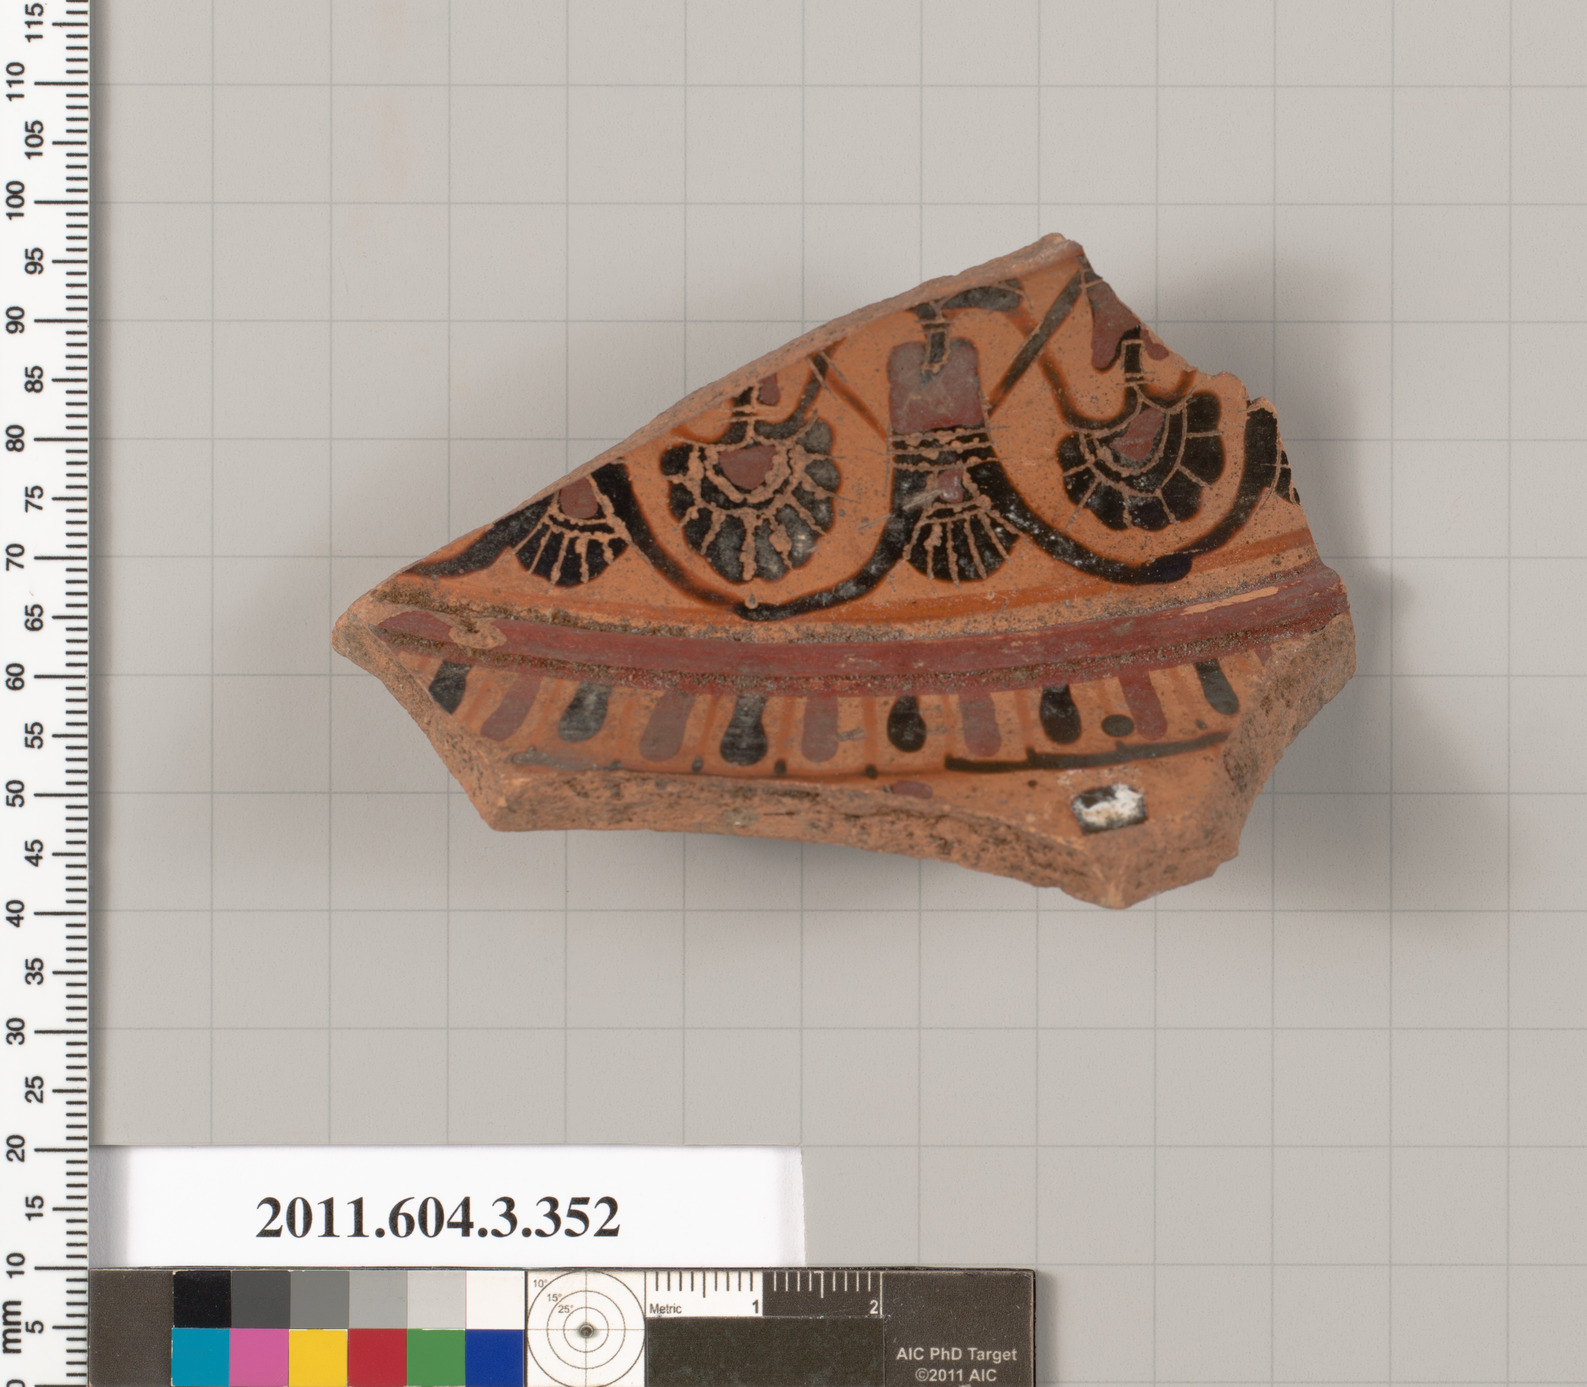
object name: neck amphora fragment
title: Terracotta fragment of a neck-amphora (jar)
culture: greek, attic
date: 575-551 BCE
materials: terracotta